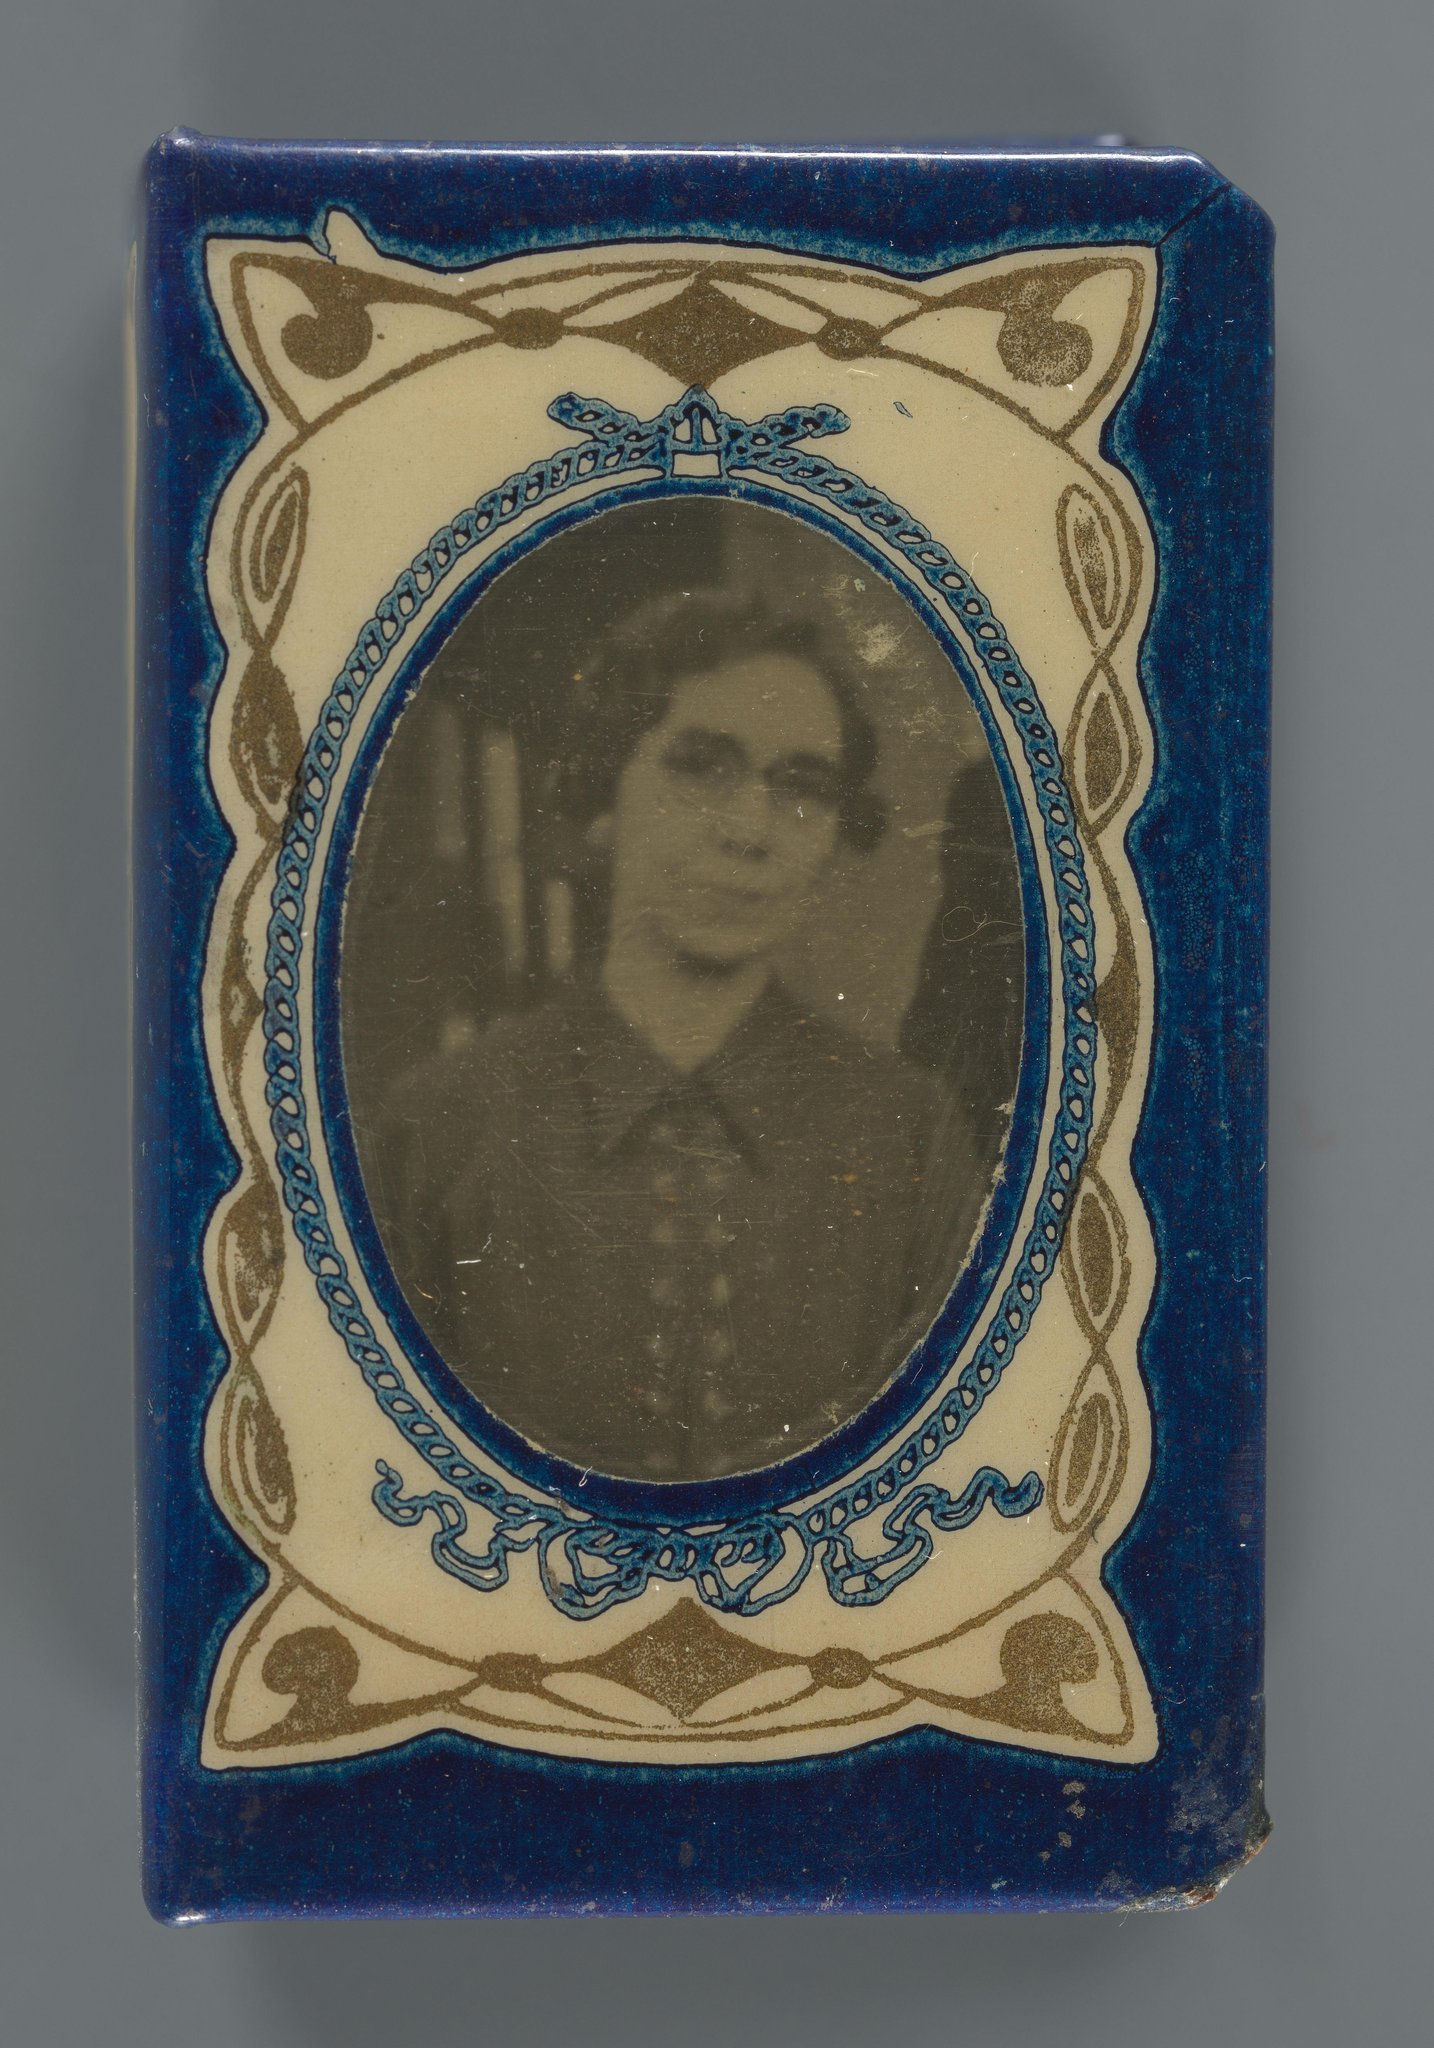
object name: photograph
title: Luciferhouder met op de voorzijde een portret van een onbekende vrouw, op de achterzijde het portret van een man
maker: Anonymous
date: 1900-1930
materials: paper, metal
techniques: gelatin silver print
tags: anonymous historical person portrayed, anonymous historical person portrayed - bb - woman